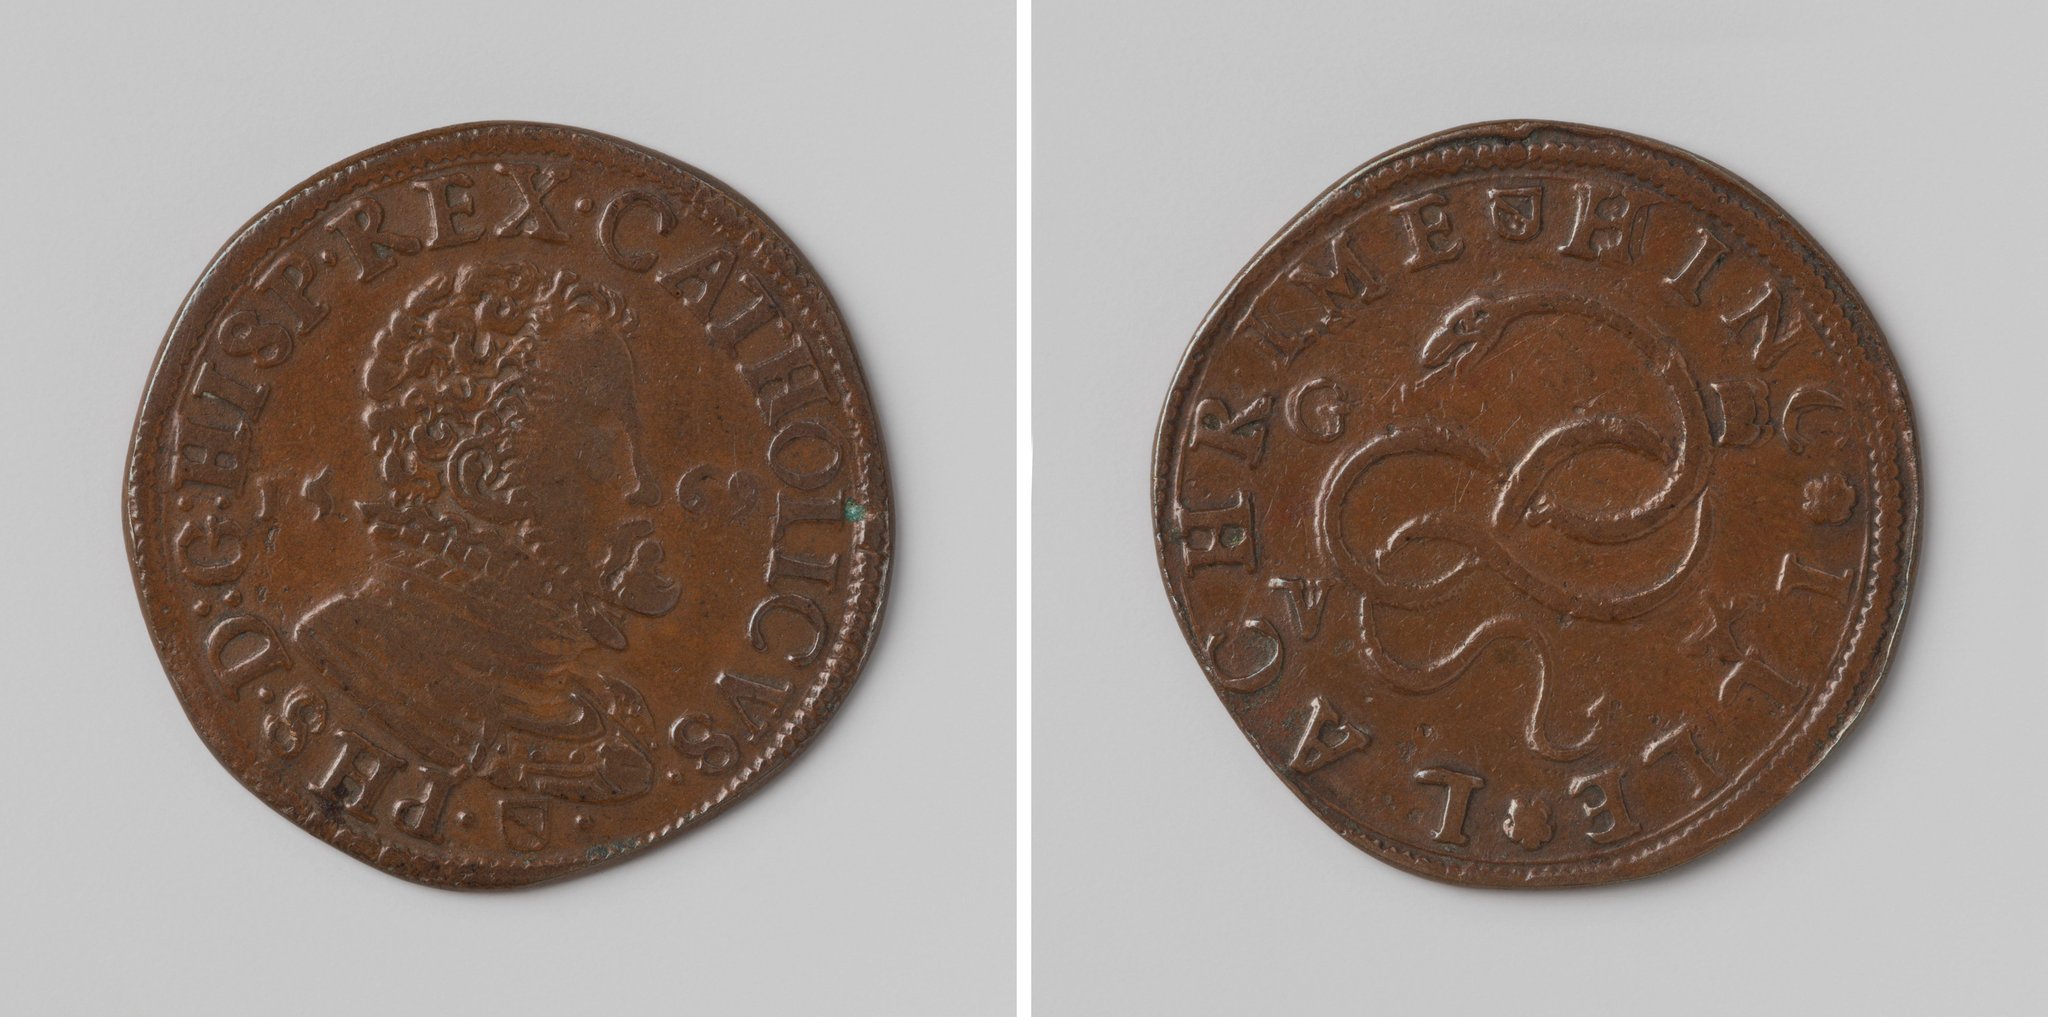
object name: jeton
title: De hertog van Alva geeft de geuzen de schuld van de bestraffing van stad en Staten van Utrecht na de weigering in te stemmen met de afkoop van de voorgestelde belastingen, ter ere van Filips II, koning van Spanje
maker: Anonymous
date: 1569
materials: copper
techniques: striking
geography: utrecht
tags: philip ii of spain, fernando álvarez de toledo (3rd duke of alba), utrecht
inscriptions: circumscription: ‘PHS D G HISP REX CATHOLICVS / 1569’, circumscription: ‘HINC ILLE LACHRIME / GEVX’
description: Koperen penning. Voorzijde: borststuk man tussen jaartal binnen omschrift. Keerzijde: kronkelende slang; daaromheen de letters G, E, V en X binnen omschrift.